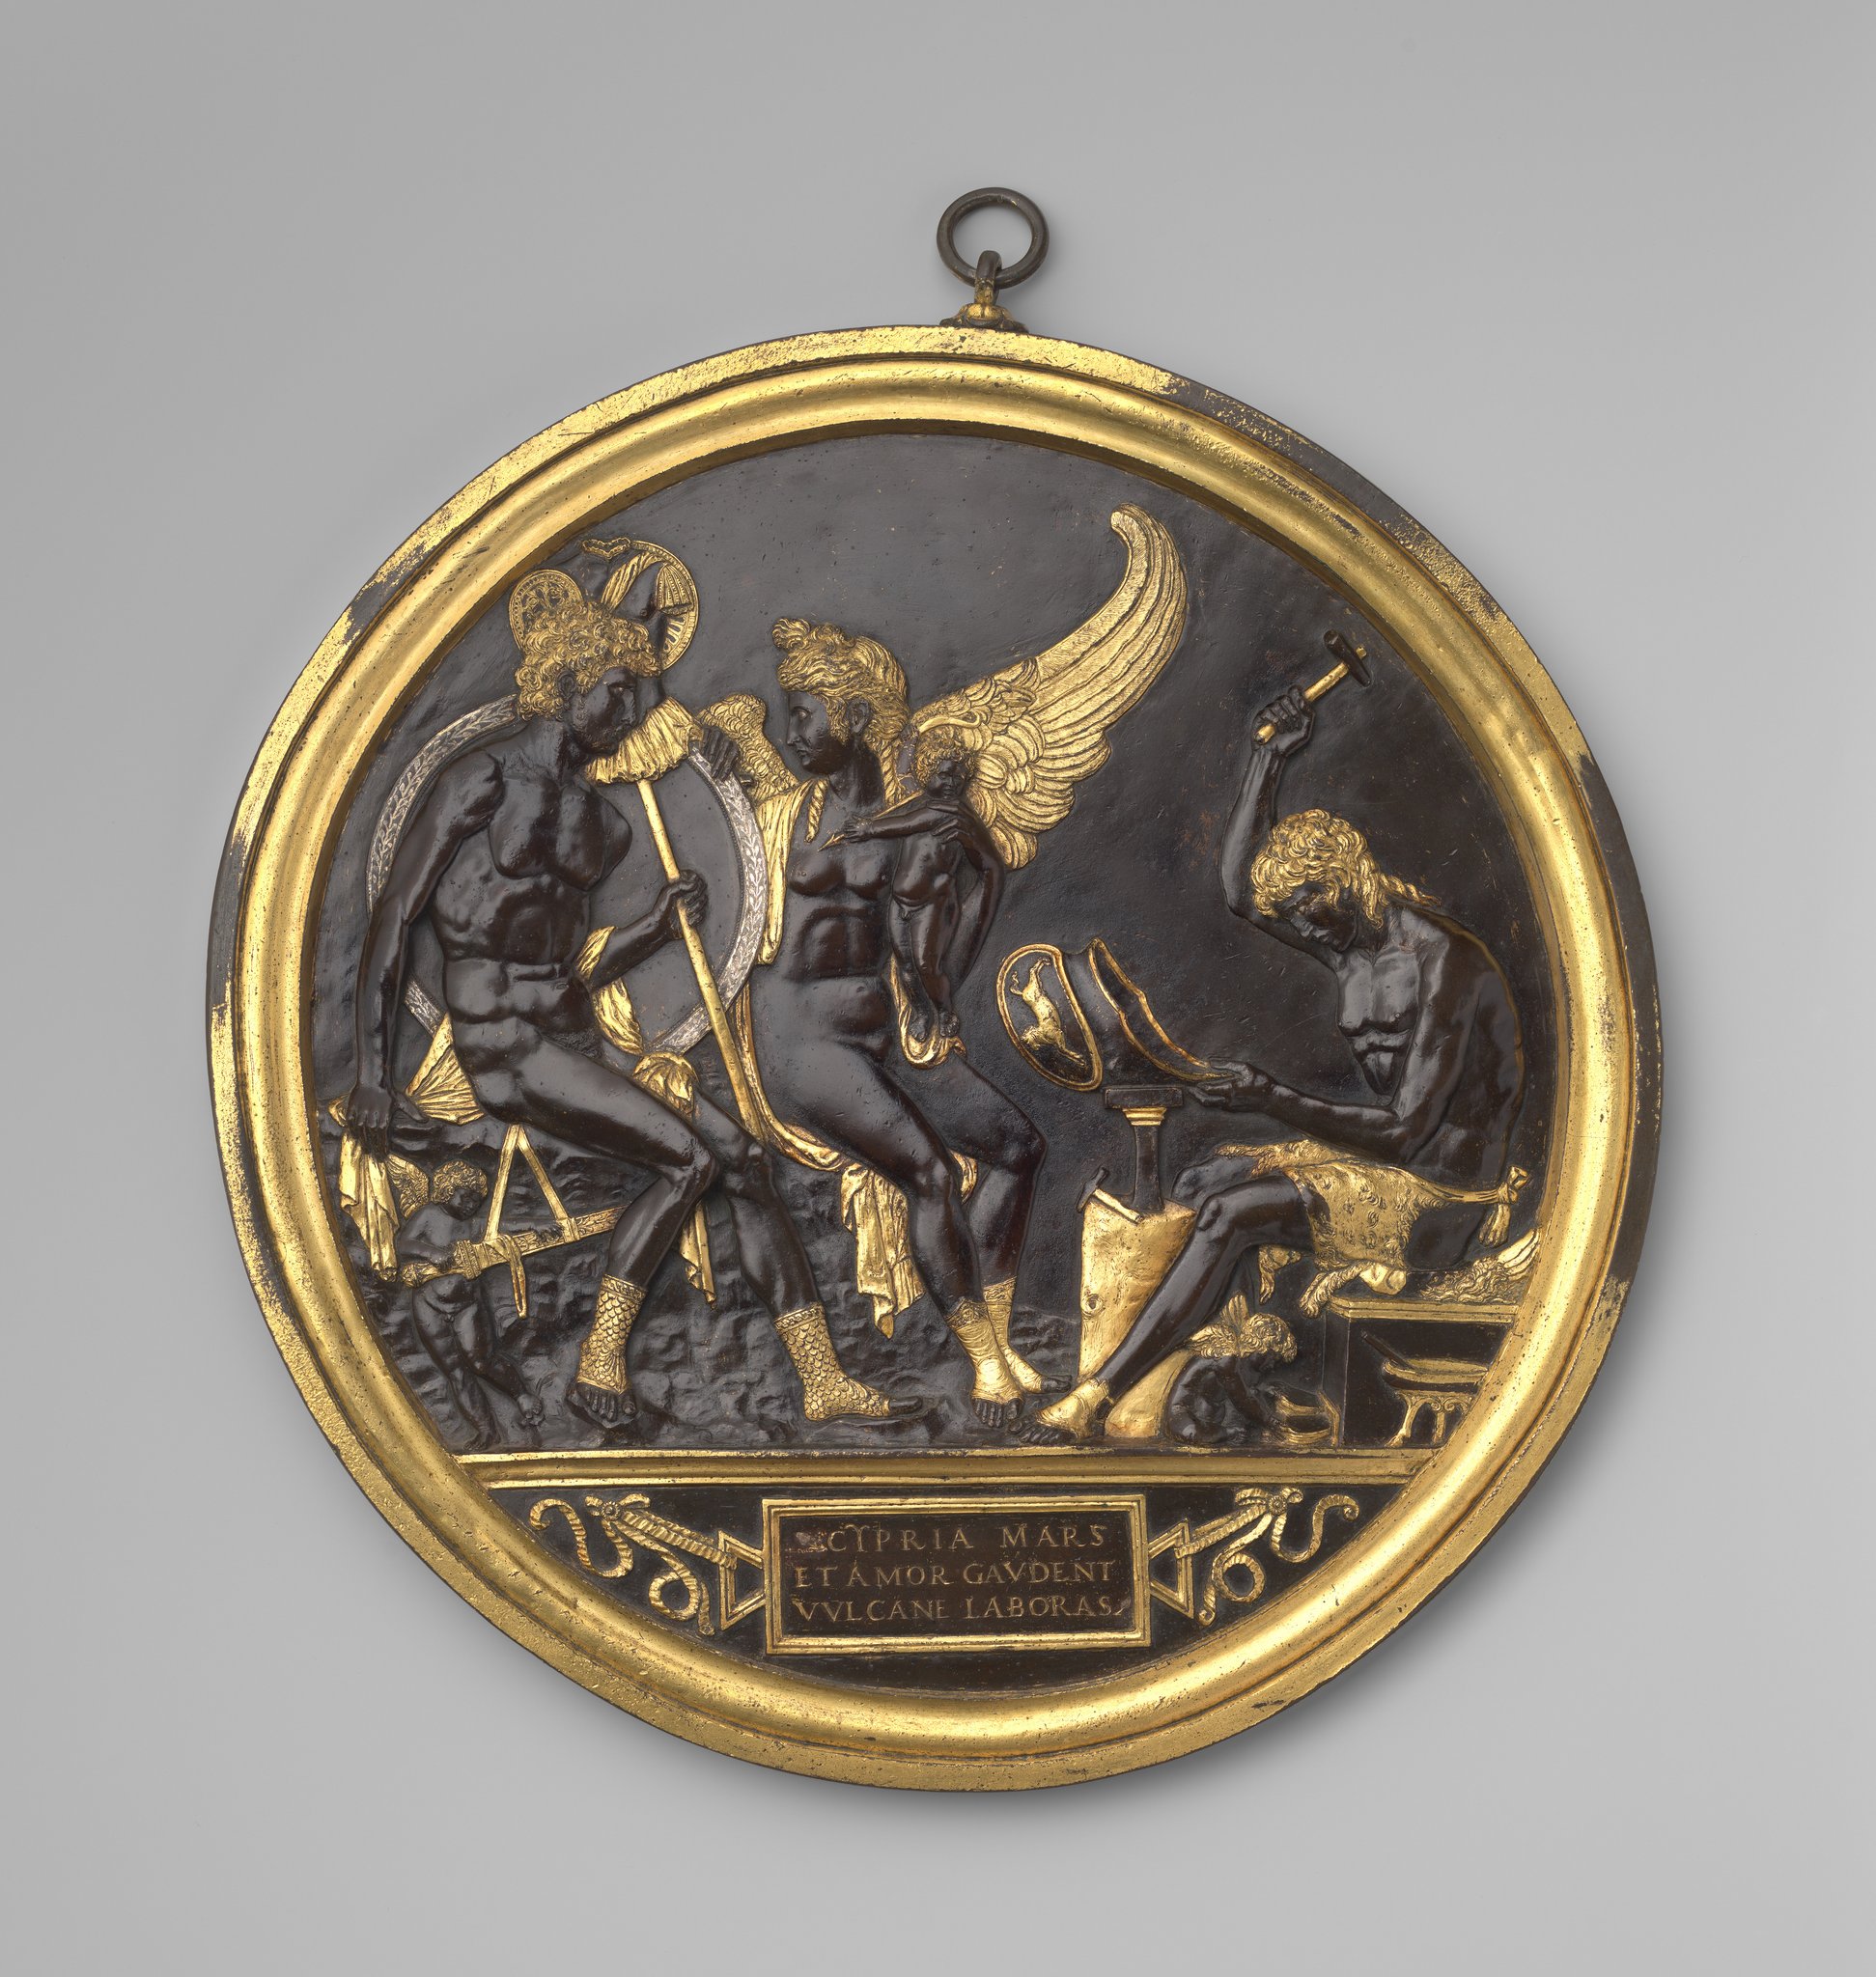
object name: roundel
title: Mars, Venus and Cupid with Vulcan at his forge (the Mantuan Roundel)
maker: gian marco cavalli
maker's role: artist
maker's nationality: italian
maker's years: 1454-1508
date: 1500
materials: gilt, gilt bronze, silver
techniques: casting, inlay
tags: helmets,cupid,mars,venus,hammers